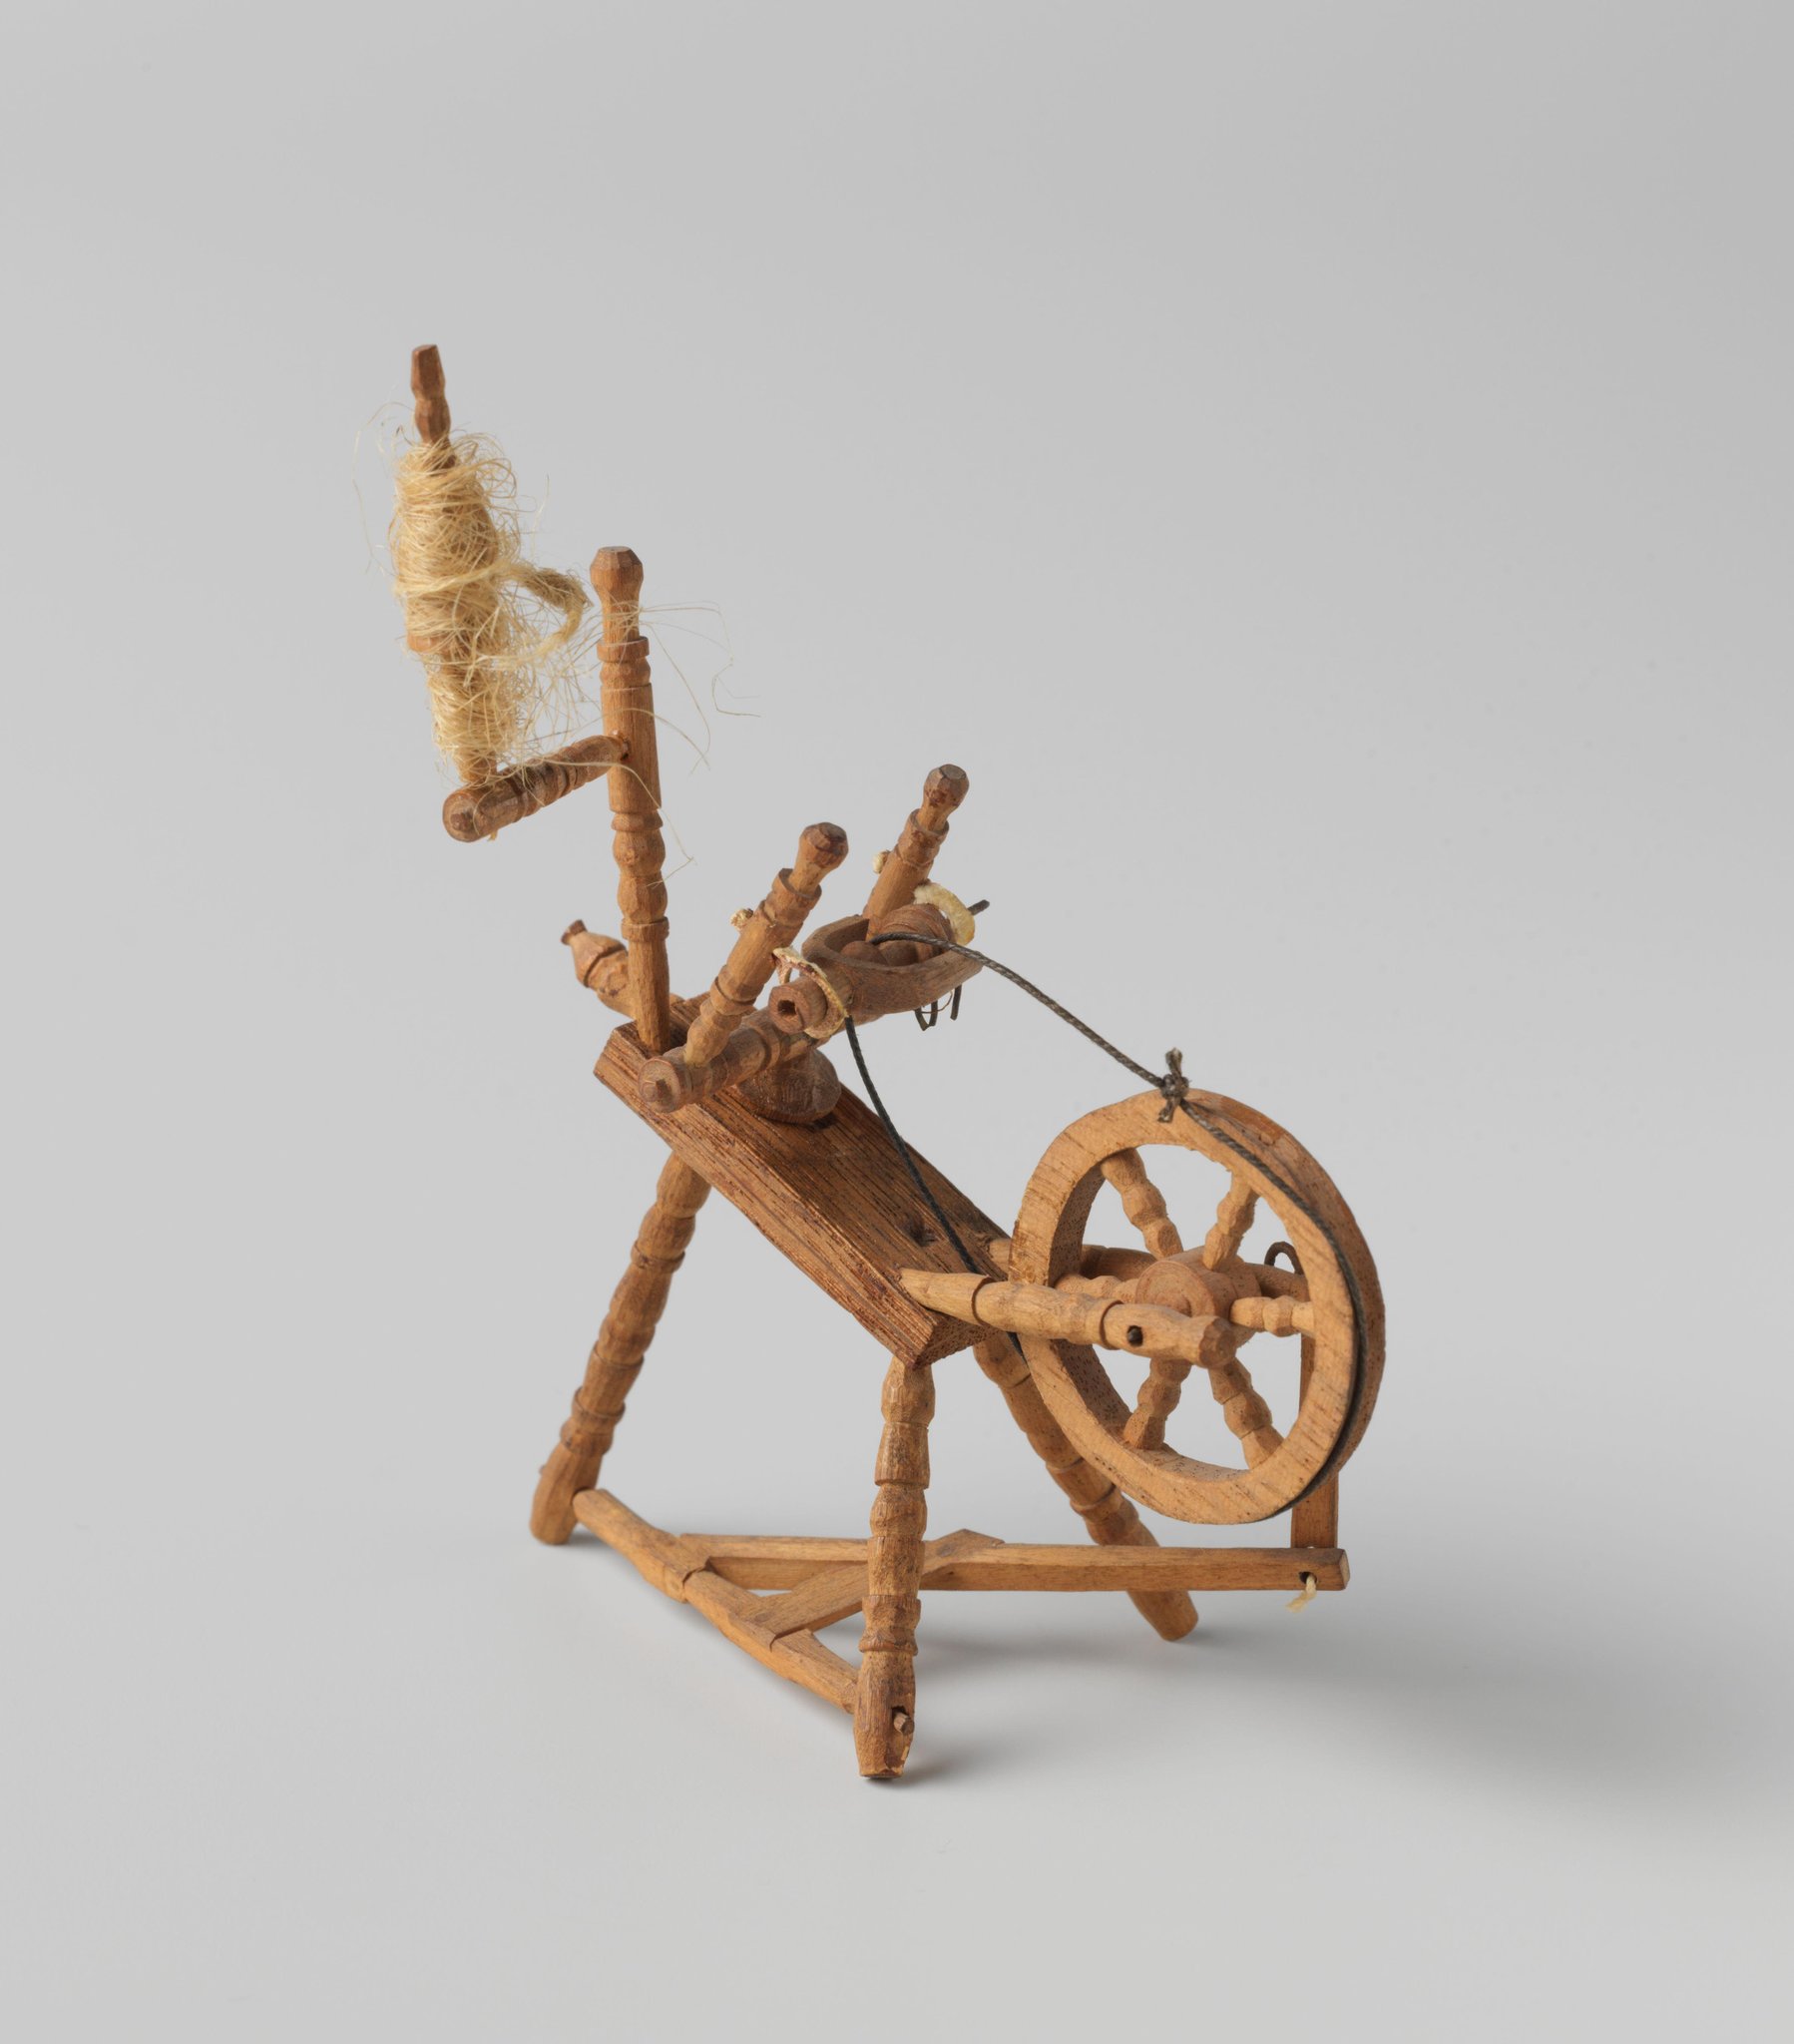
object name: spinning wheel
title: Spinnewiel, rechtopstaand model op driepoot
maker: Anonymous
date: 1700-1799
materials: wood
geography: germany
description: Een spinnewiel, rechtopstaand model van gedraaid en met diverse decoratie bewerkt been op driepoot met trappedaal verbonden met metalen slinger van het wiel dat zich in het midden tussen drie gedraaide stijlen bevindt; boven, bevestigd aan deze stijlen de spoel of spindel met vleugel en het spinrokken.